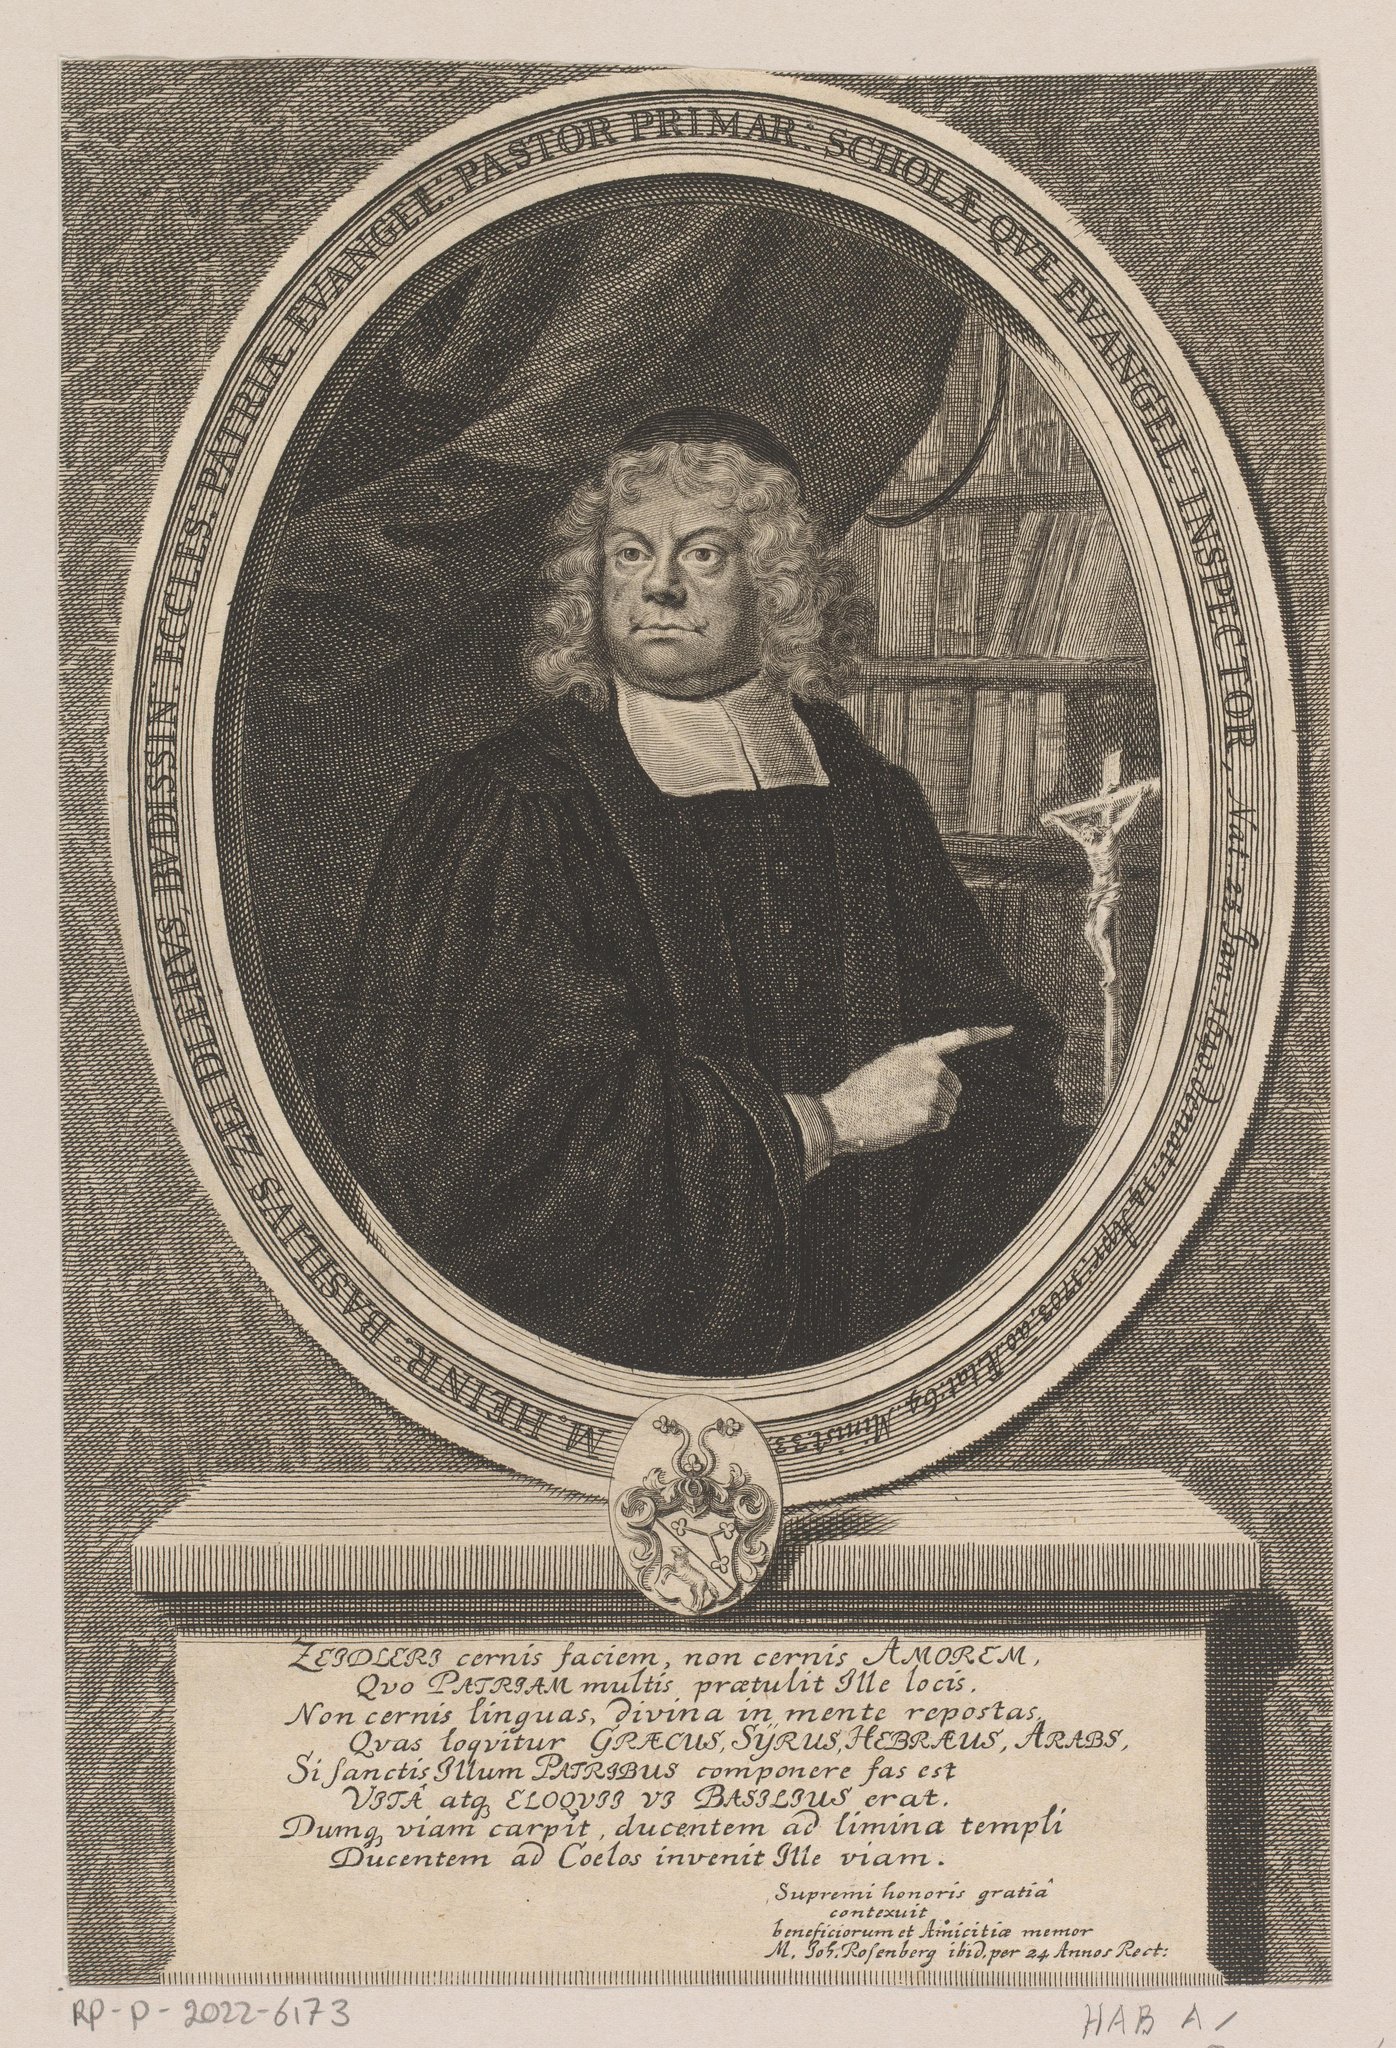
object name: print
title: Portret van Heinrich Basilius Zeidler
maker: Anonymous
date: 1703-1750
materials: paper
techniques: engraving, etching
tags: historical persons, prelates, e.g. archdeacon, canon (roman catholic)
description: Met achtregelig onderschrift in het Latijn.